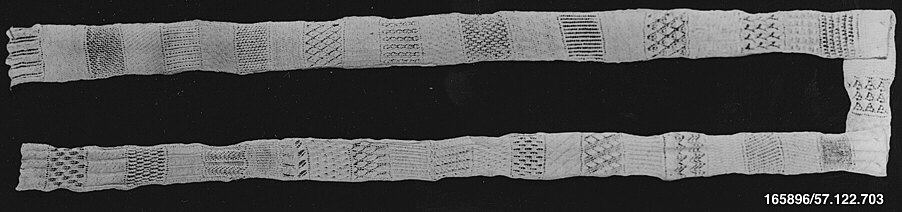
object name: sampler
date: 1801-1900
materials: cotton, lace